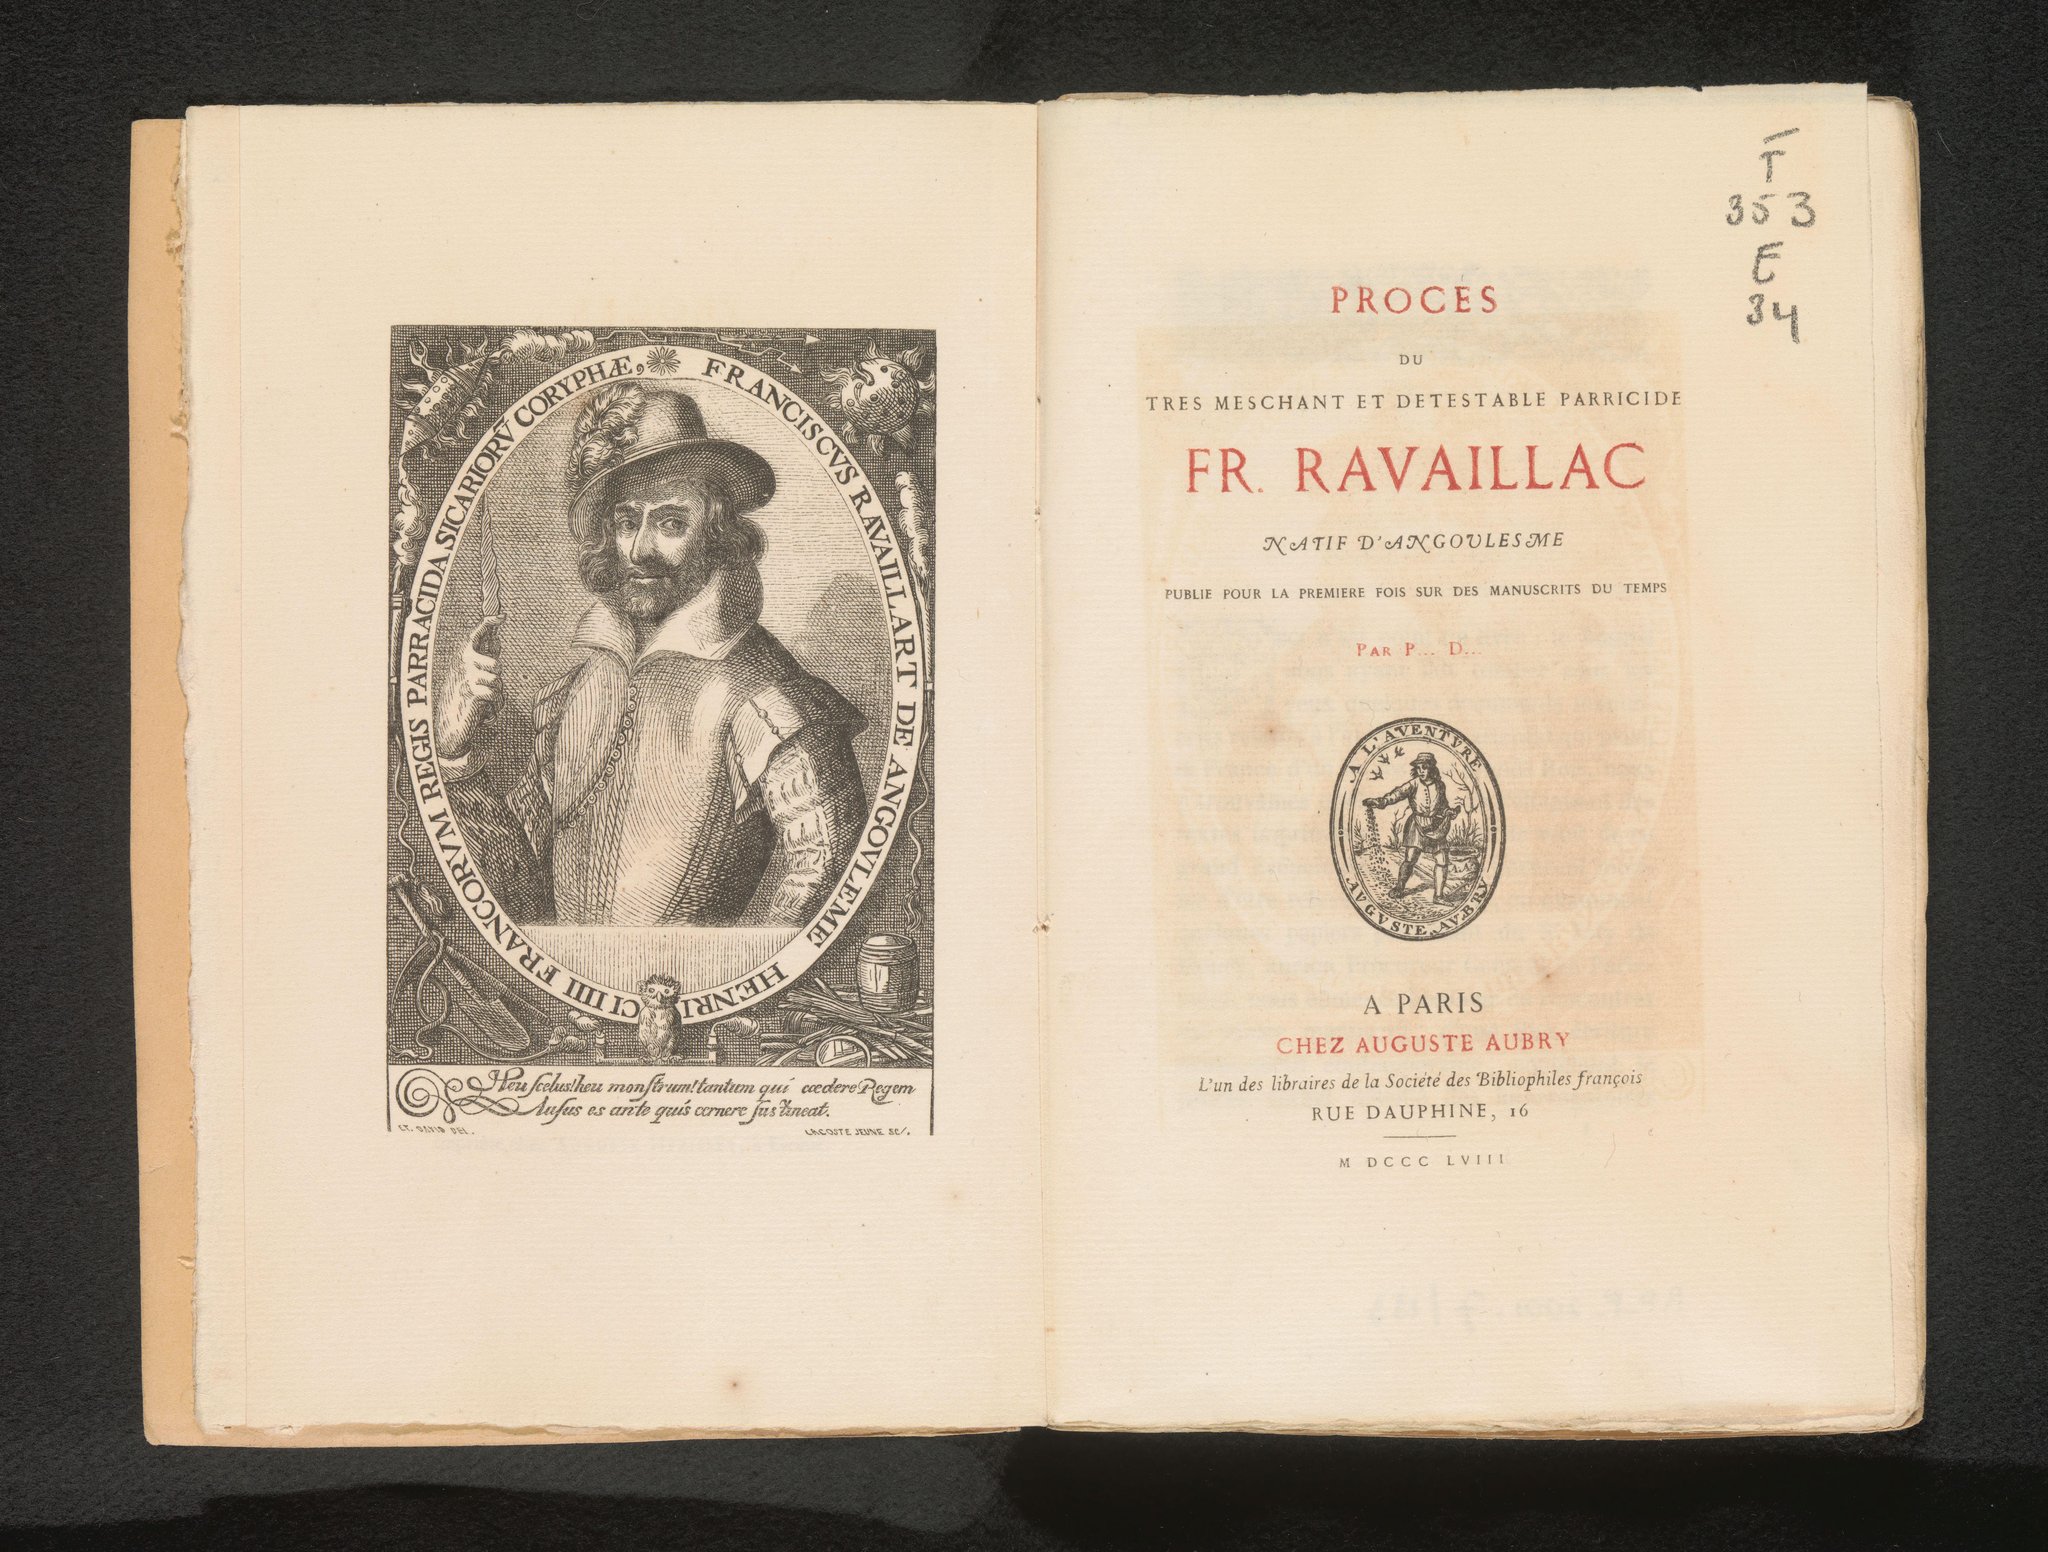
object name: page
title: Reproductie van een gravure door Crispijn van de Passe (I), voorstellende een portret van François Ravaillac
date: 1858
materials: paper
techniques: woodcut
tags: regicide, attempt, political murder, historical persons (+ full length portrait)